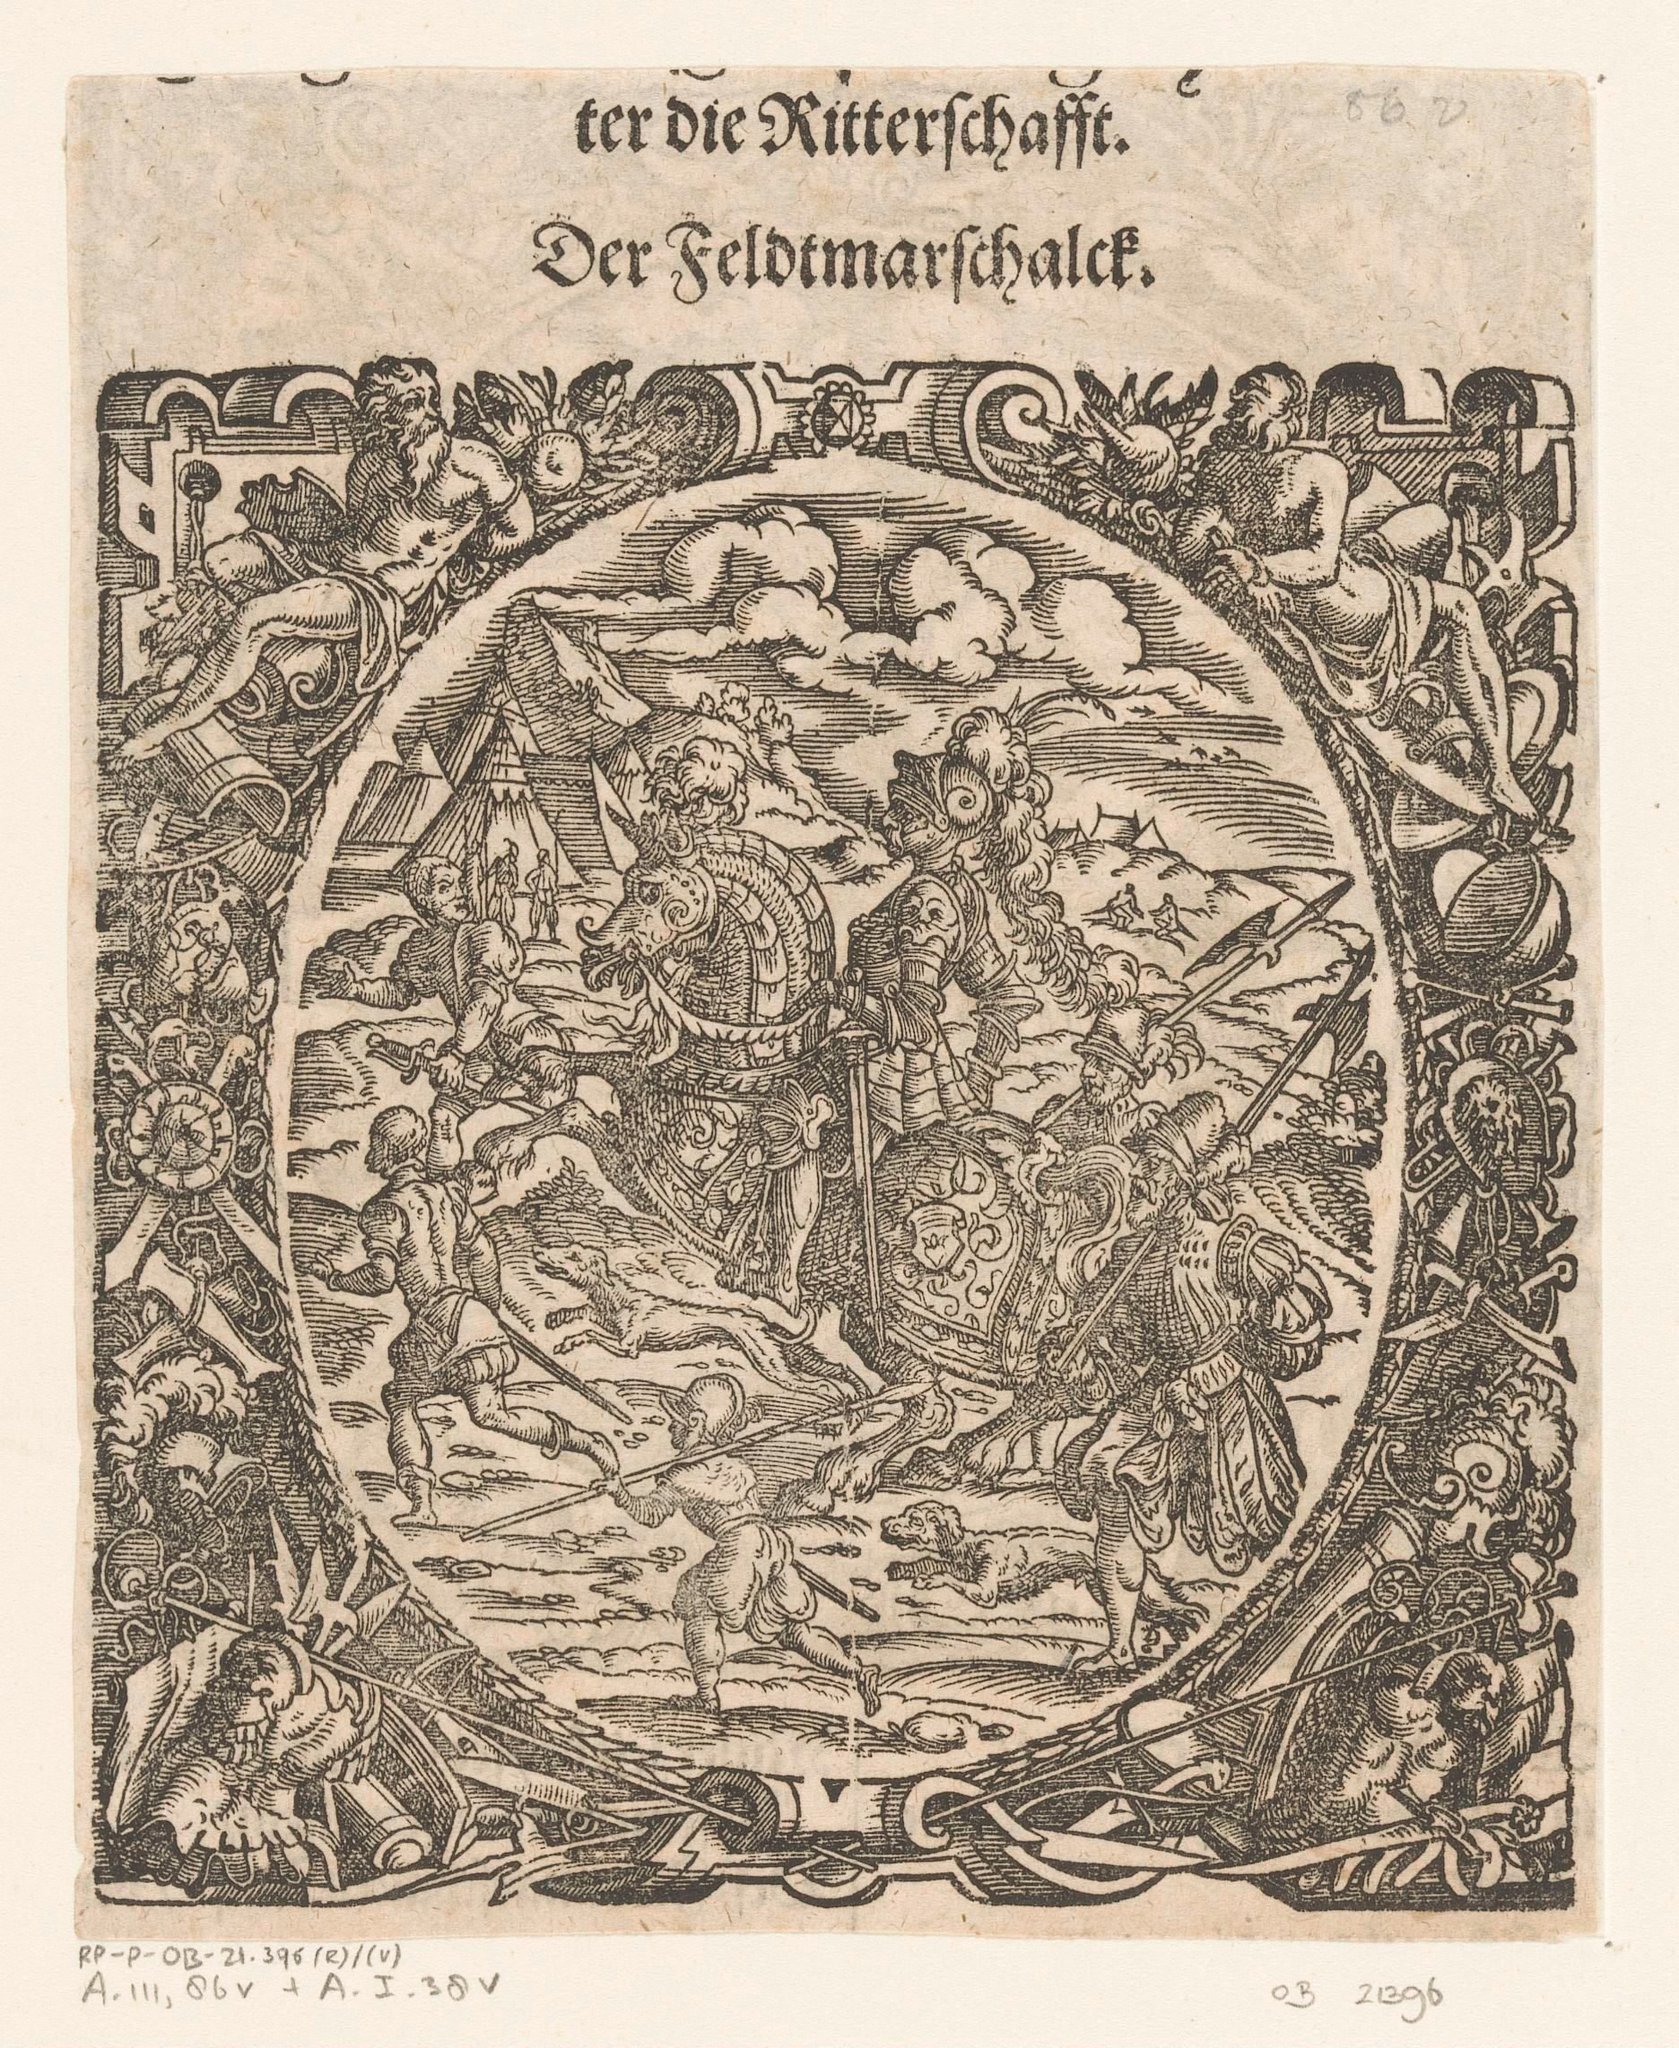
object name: book illustration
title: Der Feldtmarschalck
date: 1573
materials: paper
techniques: woodcut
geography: frankfurt am main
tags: commander-in-chief, general, marshal, warfare; military affairs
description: Zowel de voorstelling als de ornamentrand werd gebruikt voor verschillende edities van Leonhardt Fronspergers Kriegsbuch.